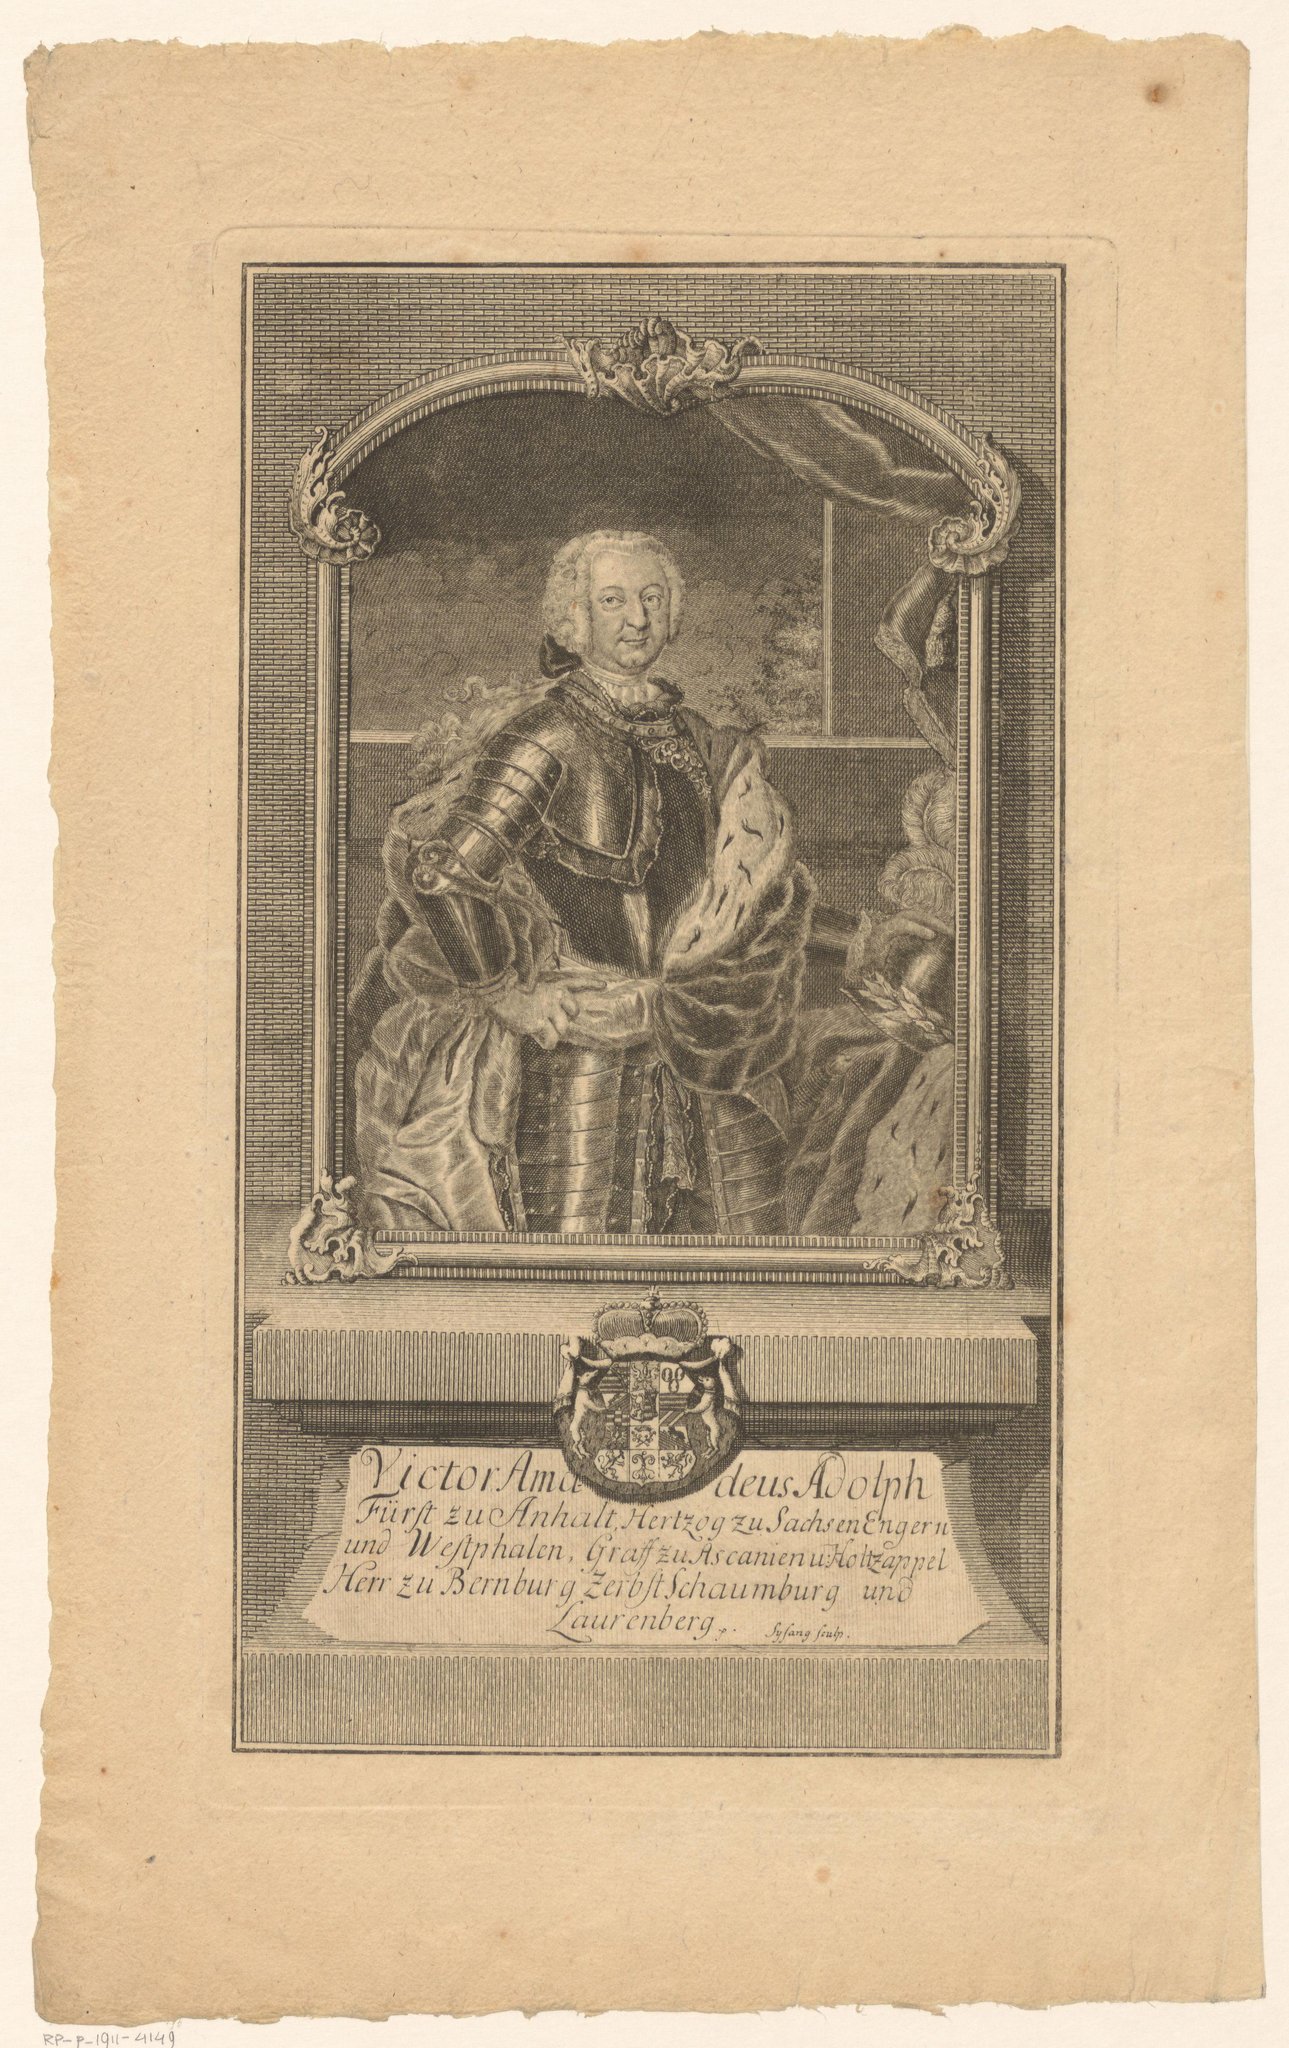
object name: print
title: Portret van Viktor Amadeus Adolf von Anhalt-Bernburg-Schaumburg-Hoym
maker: johann christoph sysang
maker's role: print maker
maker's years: 1703-1757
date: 1720-1757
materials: paper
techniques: engraving, etching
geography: germany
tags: historical persons, armorial bearing, heraldry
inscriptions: collector's mark: Lugt 2228